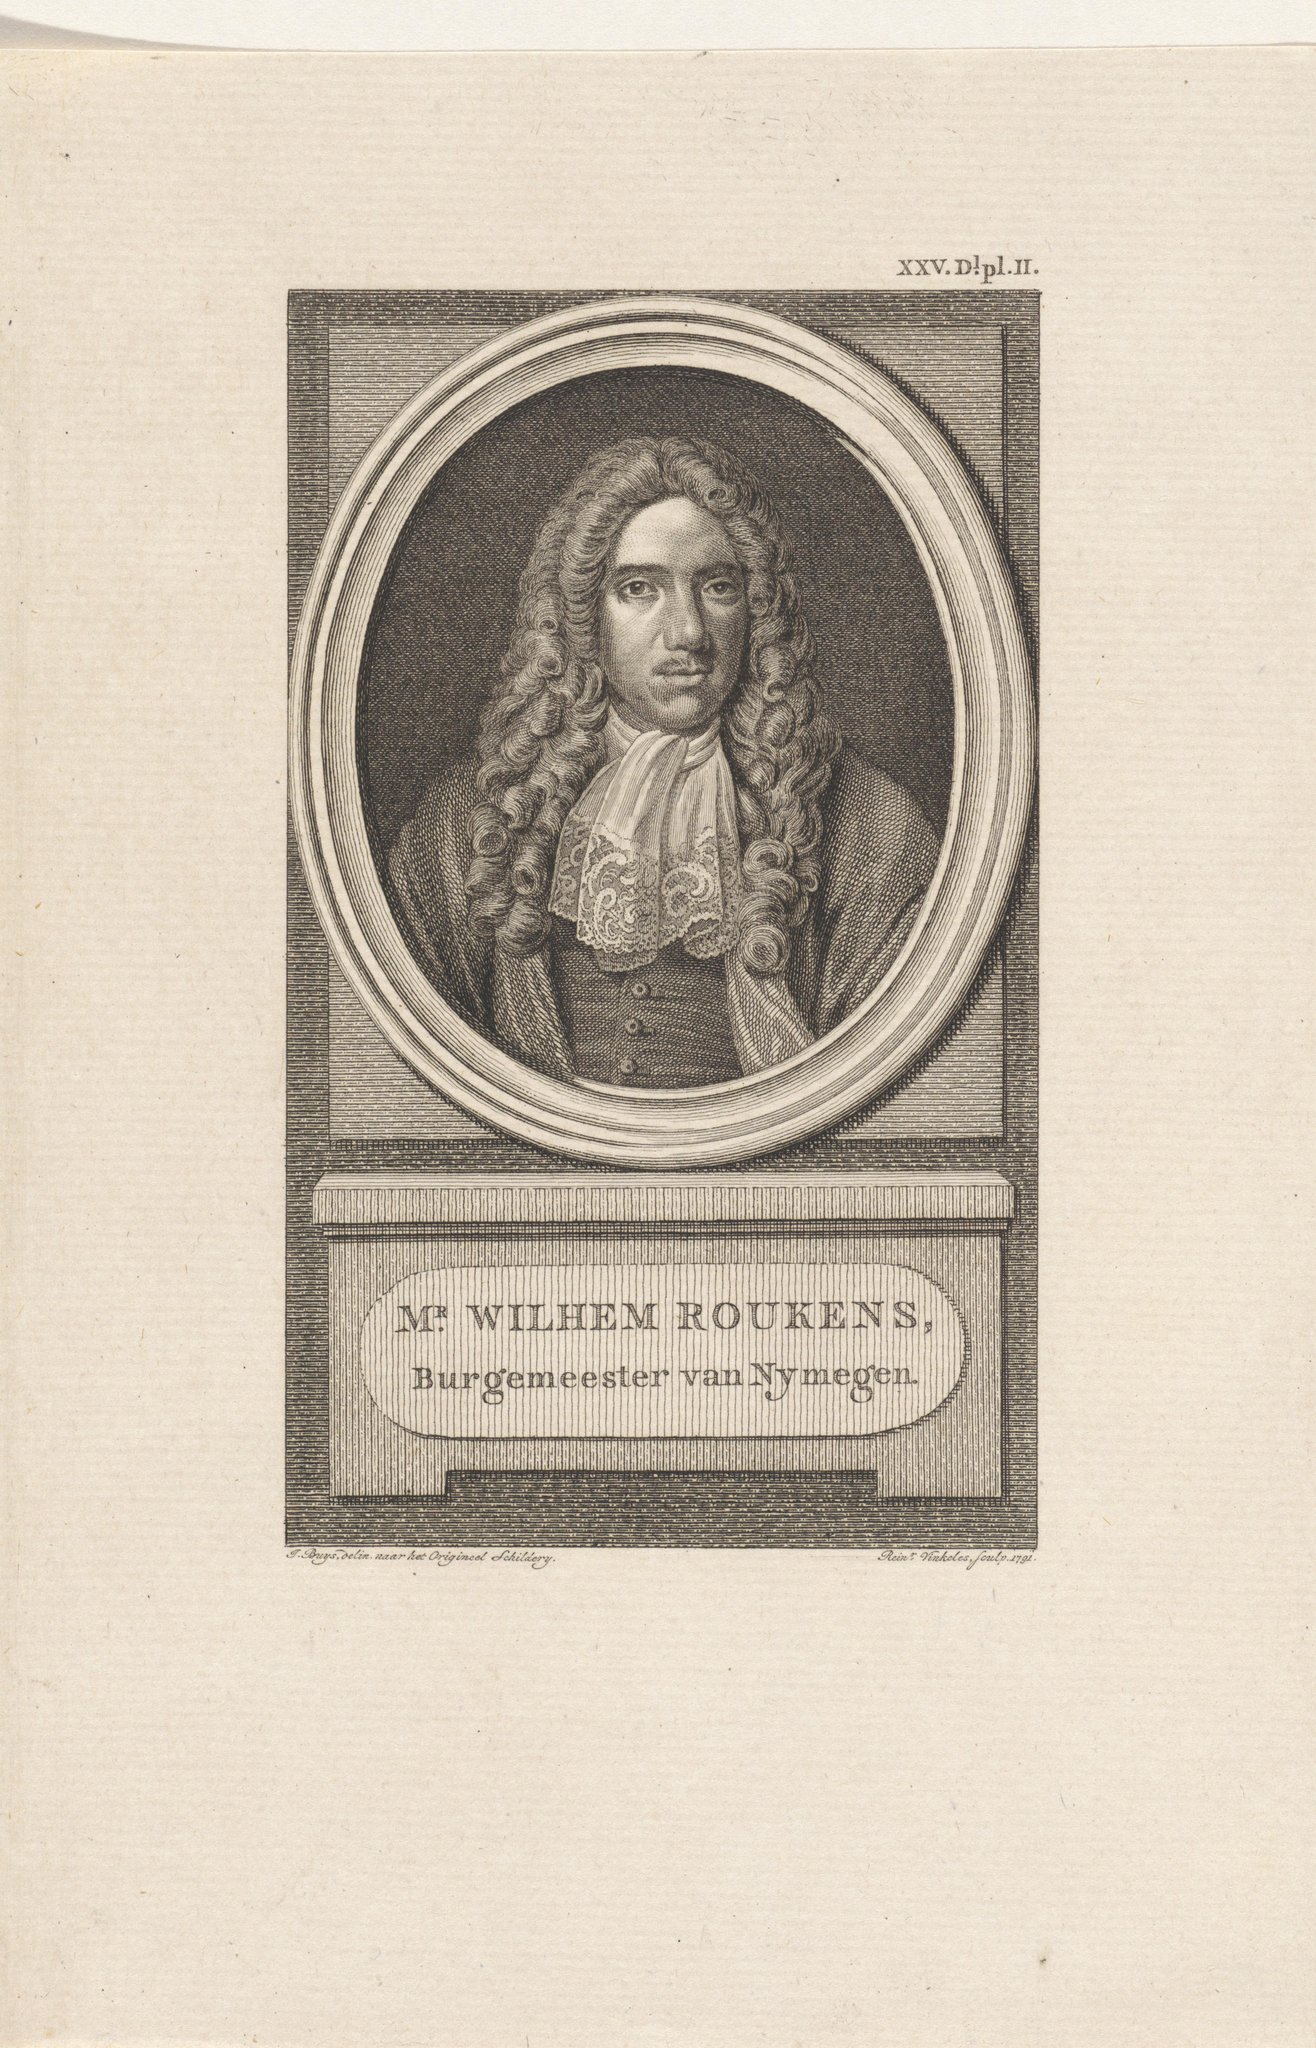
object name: book illustration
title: Portret van Willem Roukens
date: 1791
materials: paper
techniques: engraving, etching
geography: amsterdam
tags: nijmegen, mayor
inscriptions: collector's mark: Lugt 2228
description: Prent gebruikt als boekillustratie in: Kok, Jacobus. Vaderlandsch woordenboek : met kaarten, plaaten en pourtraitten. Amsterdam: Johannes Allart, 1785-1796. Deel XXV.